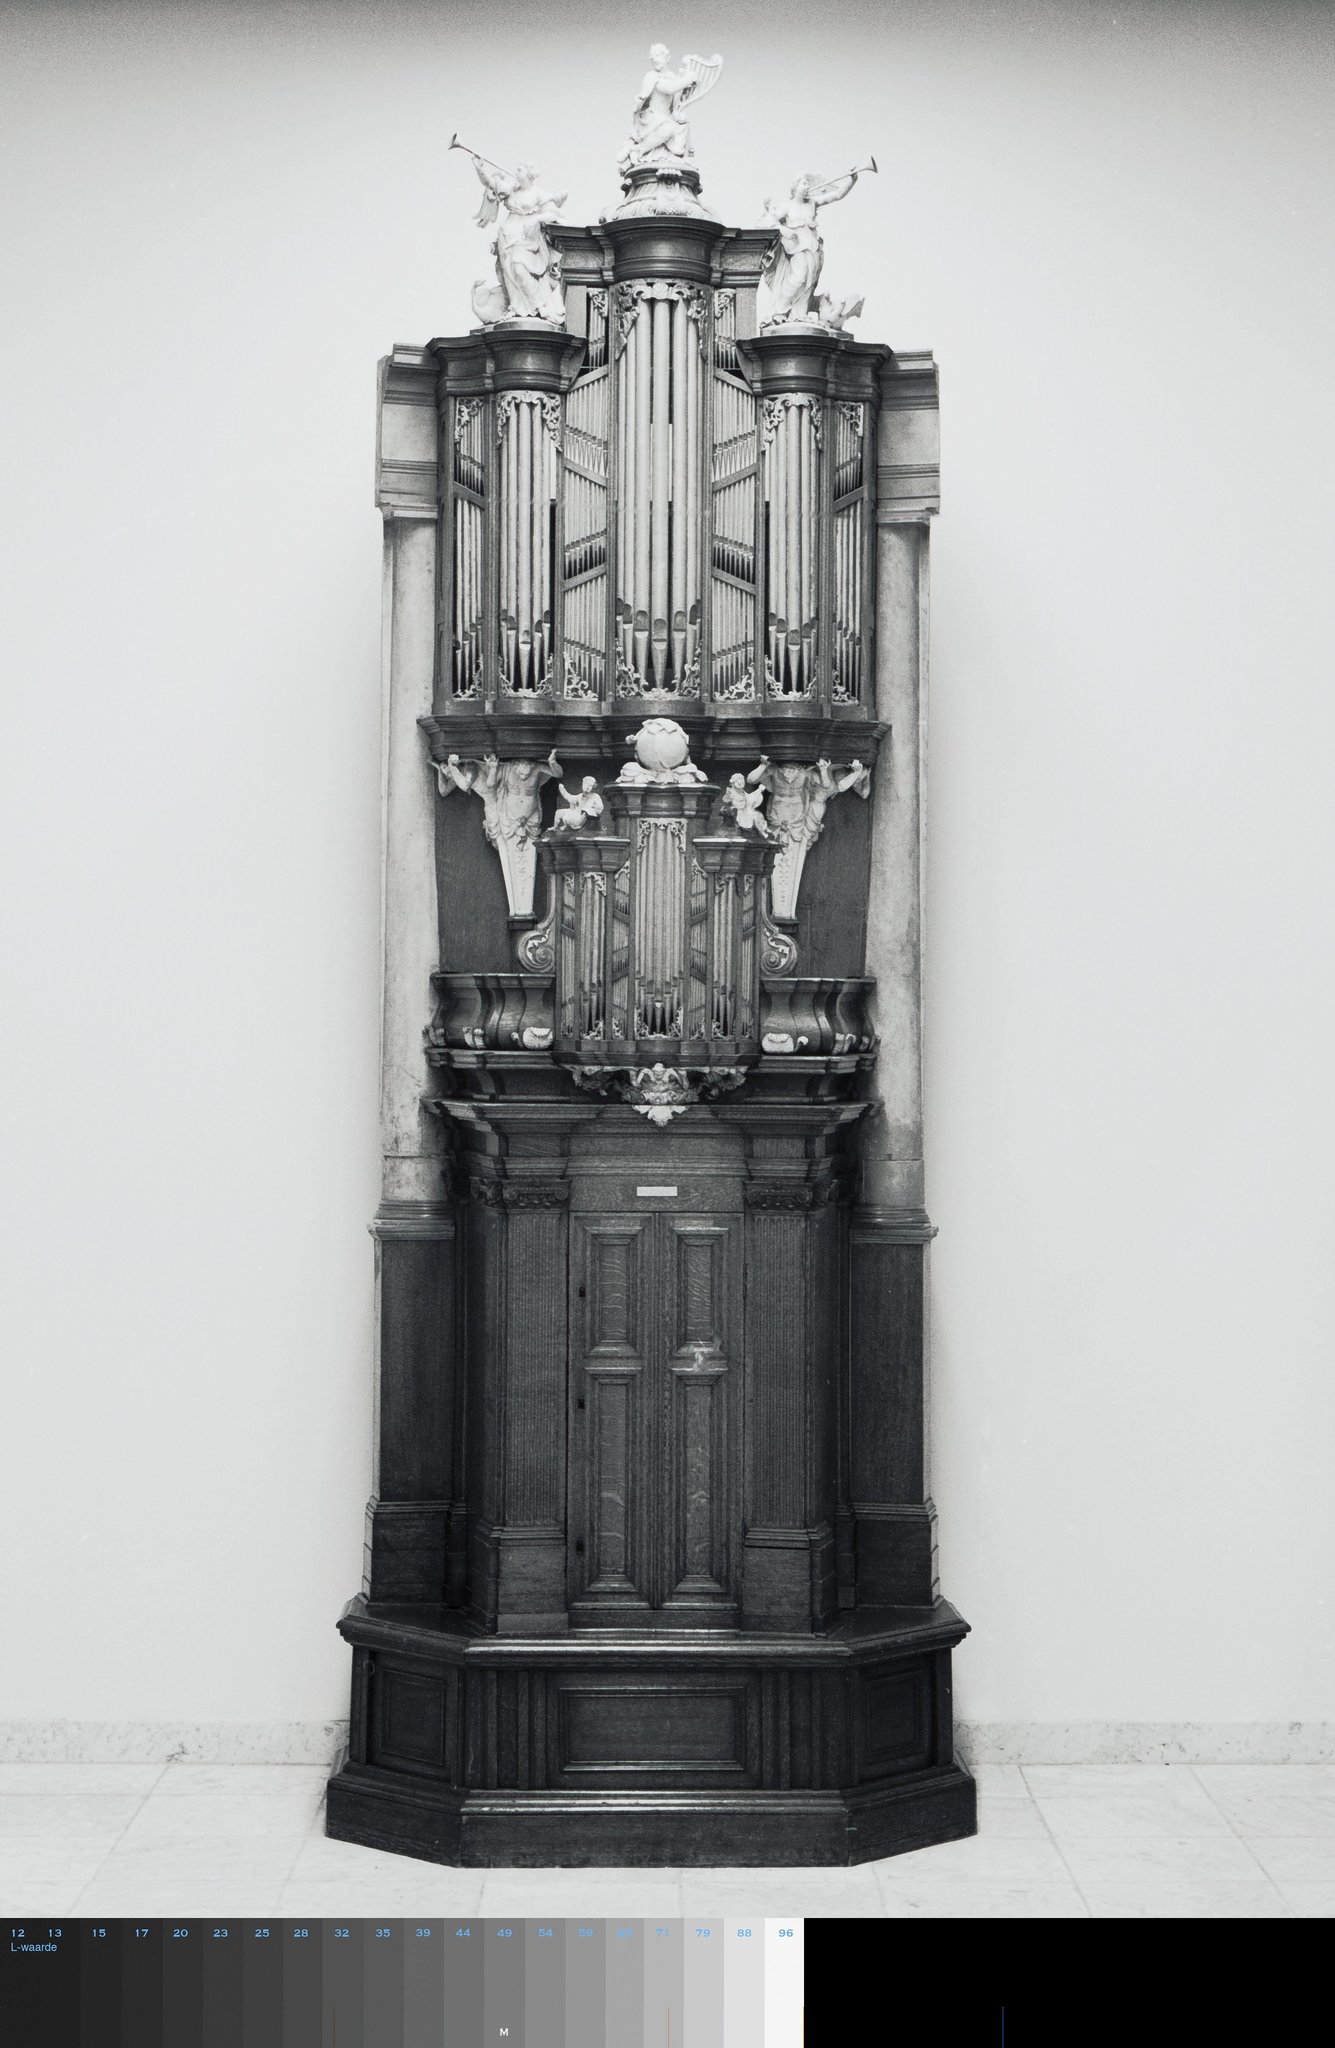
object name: furniture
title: Model of the organ in the Lutheran Church at the Stroomarkt in Amsterdam, before the fire in 1823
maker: Anonymous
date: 1710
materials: lead, wood, paint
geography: northern netherlands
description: Model of the organ in the Lutheran Church in Amsterdam. Amsterdam, c. 1715 - 1719. The organ, which was built in 1719, perished when the Lutheran church was burnt in 1823.